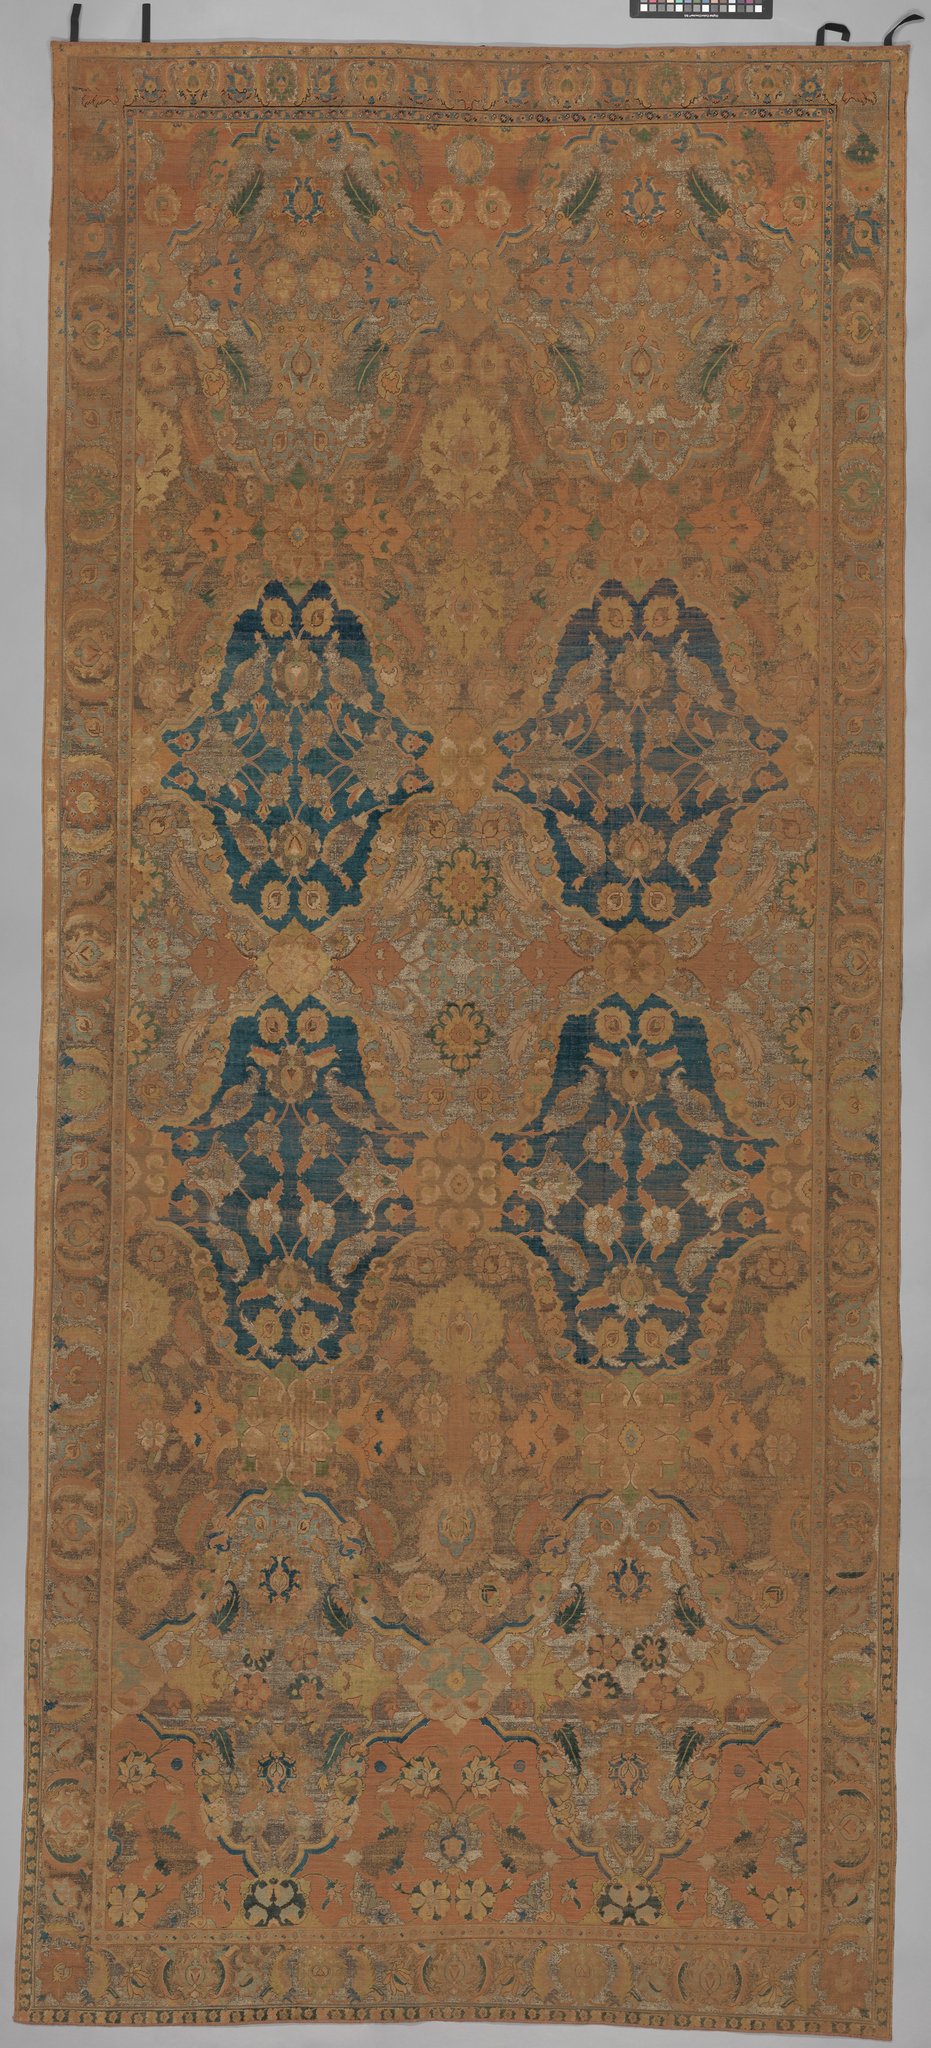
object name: carpet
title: 'Polonaise' Carpet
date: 1601-1700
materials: cotton, metal thread, silk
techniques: asymmetrically knotted pile, brocade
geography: iran